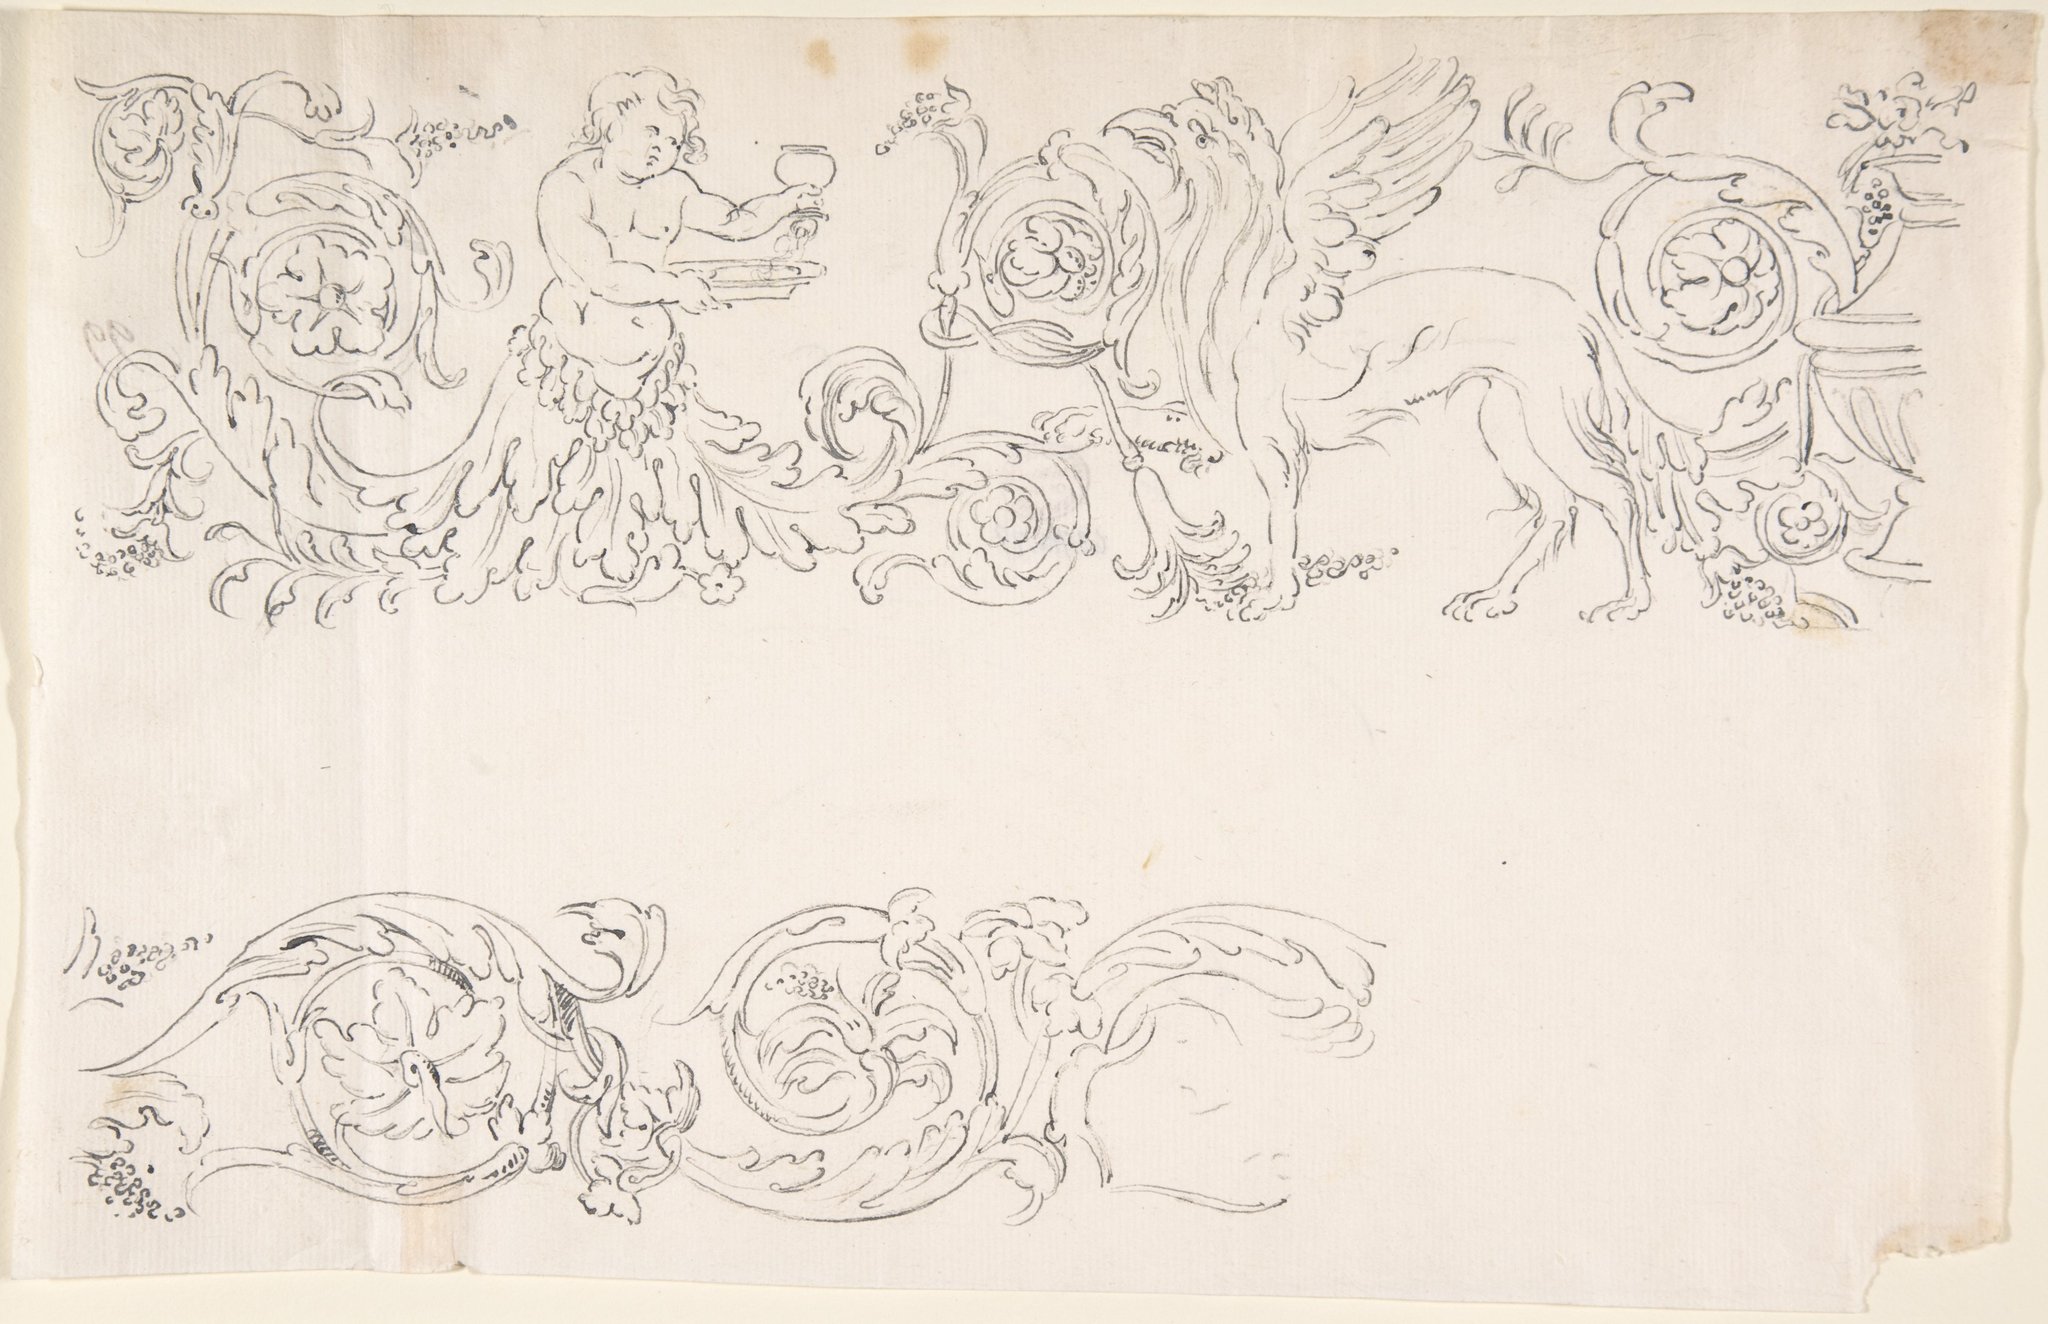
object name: drawing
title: Designs for Decorative Borders with Floral Ornamentation and a Putto and Griffin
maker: anonymous, italian, 17th century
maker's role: artist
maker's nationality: italian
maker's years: 1600-1700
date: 1650-1750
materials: graphite, ink, drawing material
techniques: pen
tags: ornament,griffins,putti